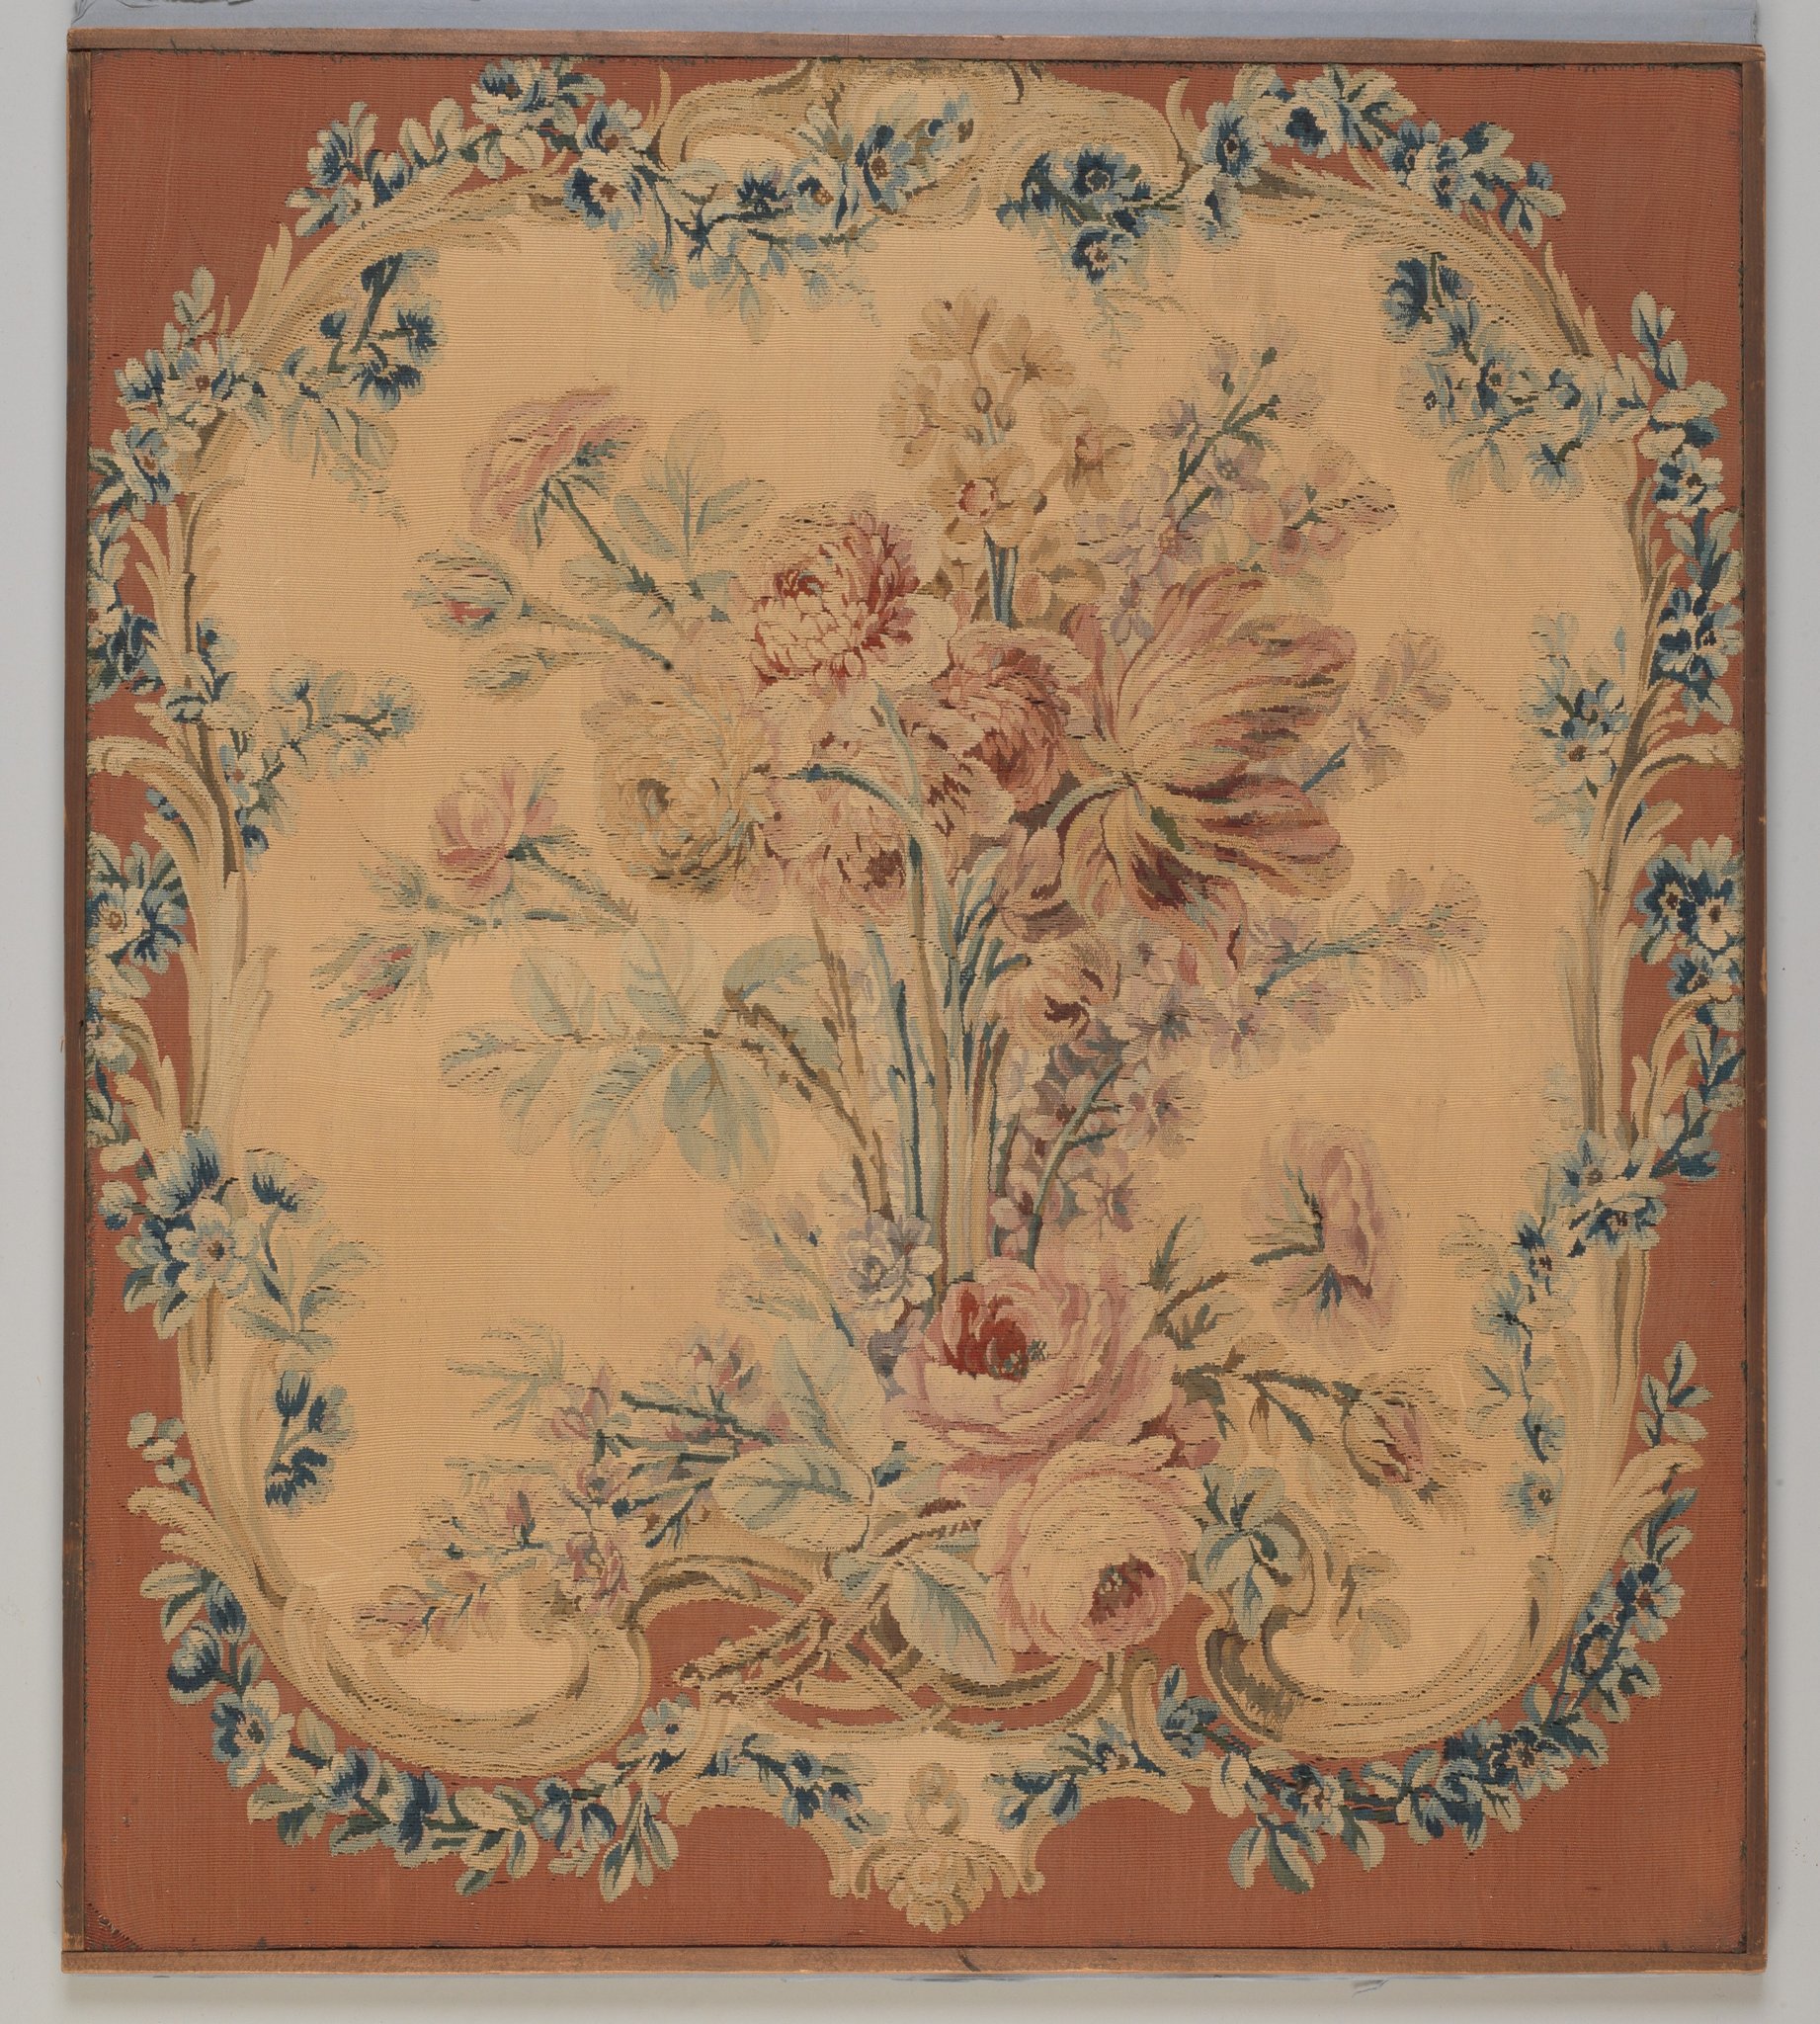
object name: upholstery panel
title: Pair of chair backs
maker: maurice jacques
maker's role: designer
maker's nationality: french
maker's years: 1712-1784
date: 1760-1780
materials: silk, wool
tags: flowers